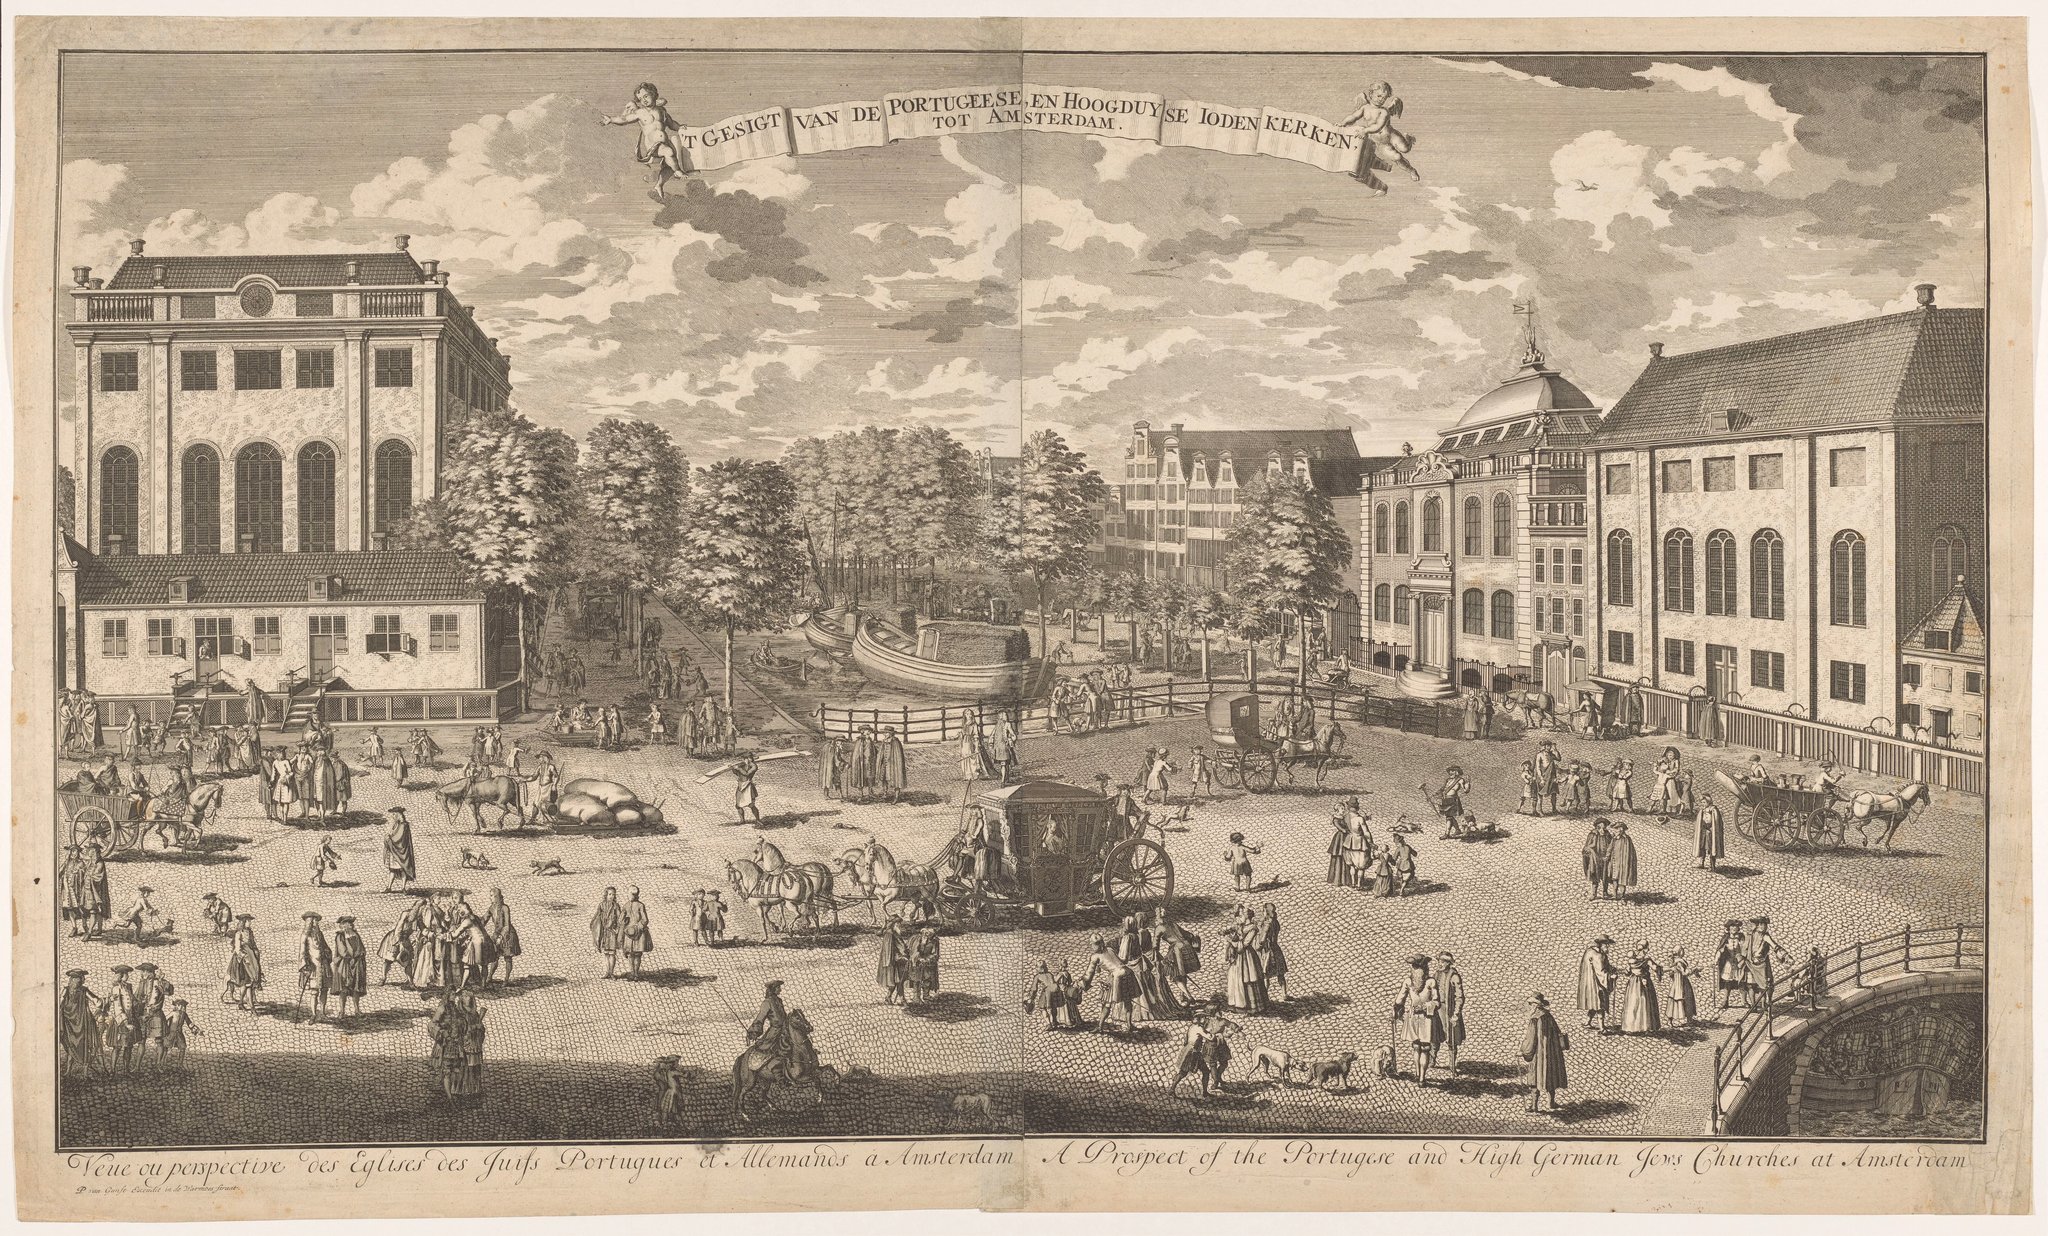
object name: print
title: Gezicht op de Hoogduitse en Portugese synagoge van Amsterdam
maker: pieter van gunst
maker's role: print maker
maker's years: 1658-1731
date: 1659-1731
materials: paper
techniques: etching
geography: amsterdam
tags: 'sephardim' ~ jewish communities, 'ashkenazim' ~ jewish communities, the synagogue (as building and place of worship ~ jewish religion), church (exterior), street (+ city(-scape) with figures, staffage), amsterdam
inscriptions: collector's mark: Lugt 2233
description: De Hoogduitse en Portugese synagoge van Amsterdam. Op de voorgrond de straat met wandelaars, venters, een koets met paarden en een brug over een kanaal. Twee putti in de lucht houden een banderol met de titel omhoog.